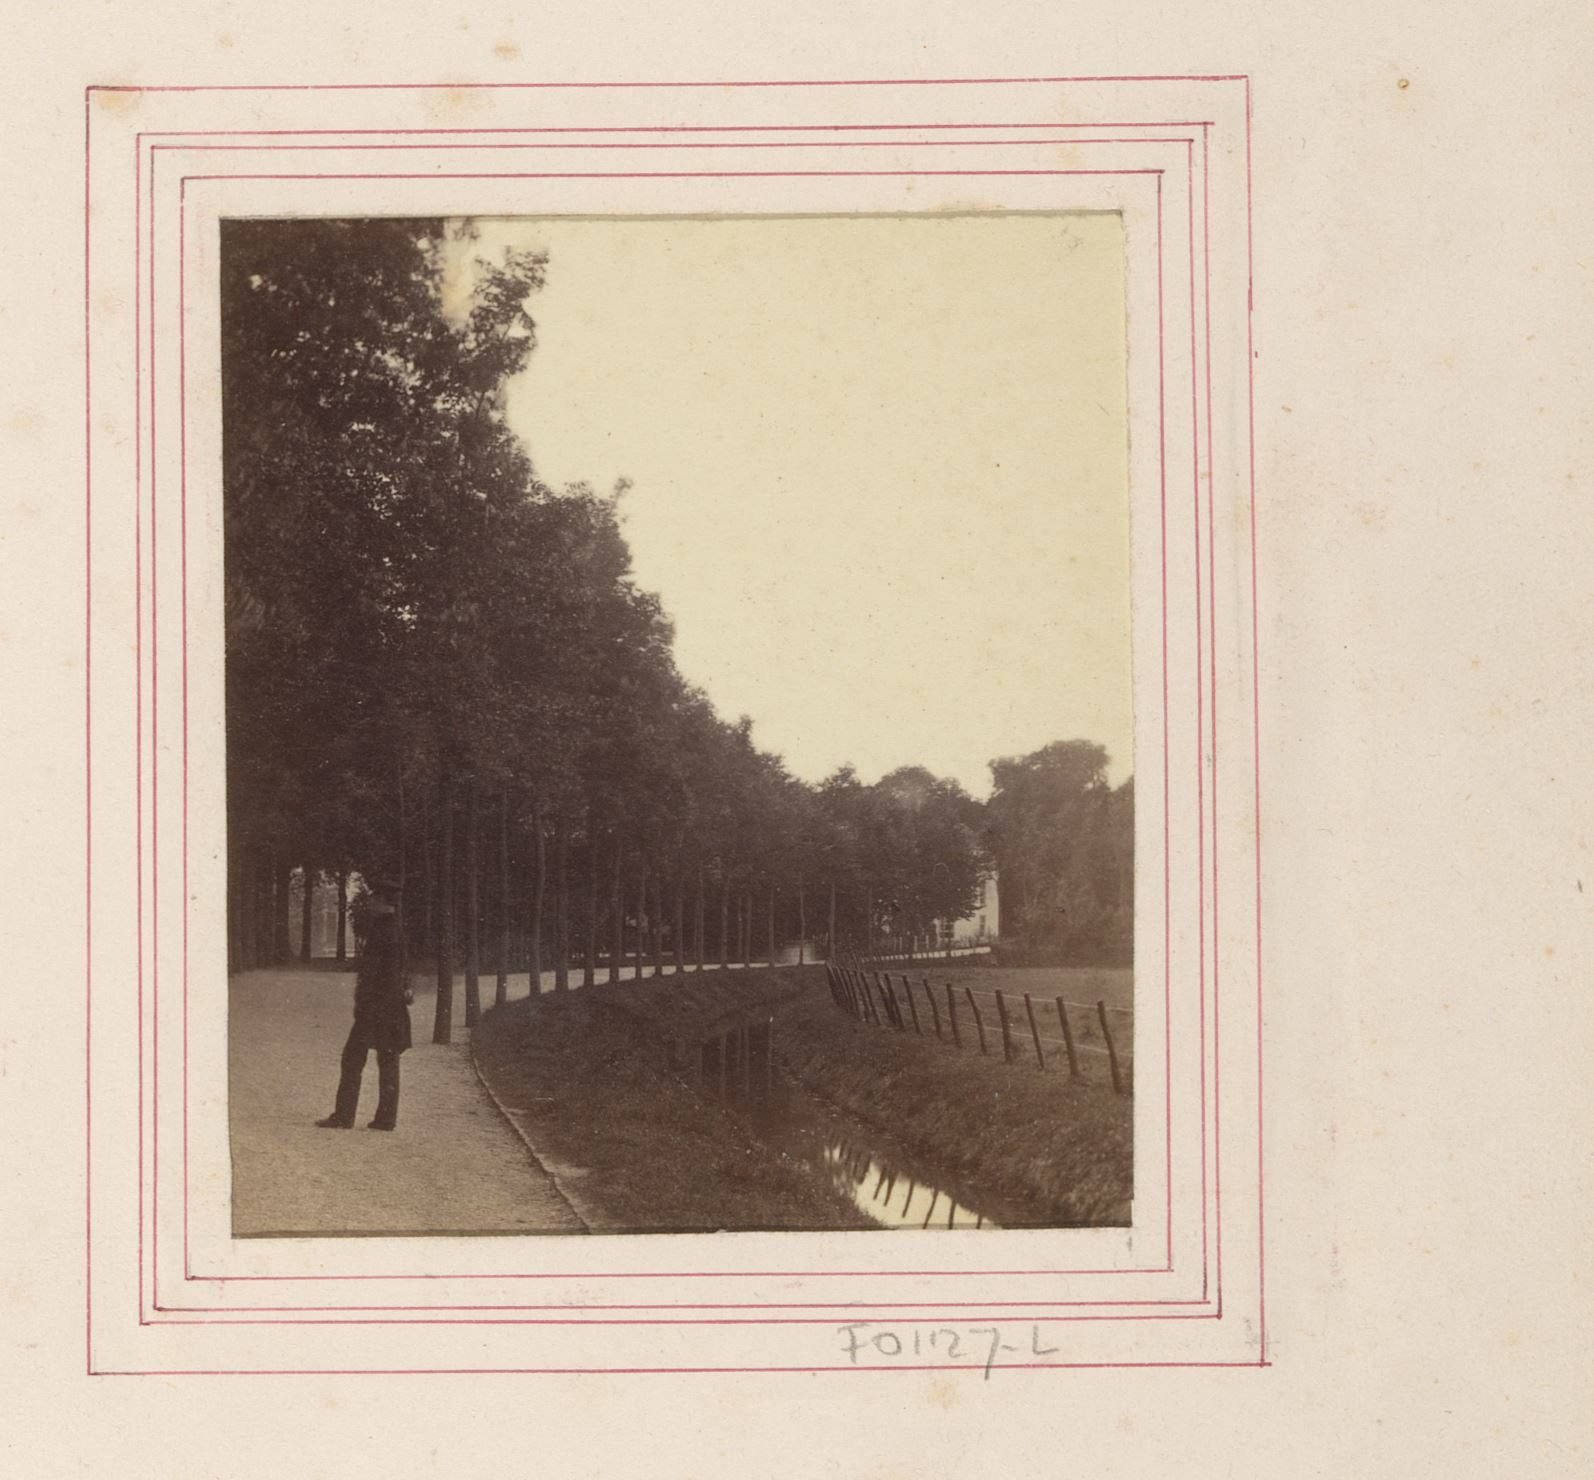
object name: photograph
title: Onbekende man poserend op straat langs sloot in Den Haag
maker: Anonymous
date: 1870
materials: photographic support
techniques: albumen print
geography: the hague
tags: adult man, small canal, ditch, street (+ city(-scape) with figures, staffage), the hague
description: Onderdeel van Album met foto's en litho's van bezienswaardigheden in Noord- en Zuid-Hollandse steden, schilderijen en klederdrachten.